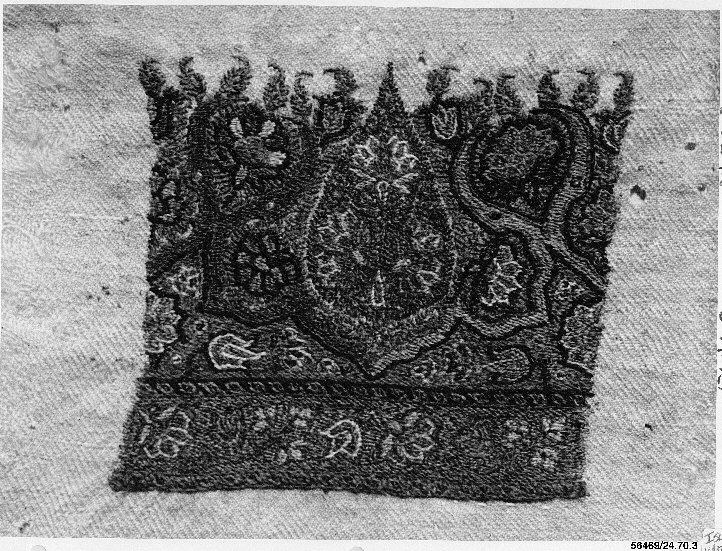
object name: shawl fragment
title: Shawl Sample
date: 1801-1833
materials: wool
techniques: embroidery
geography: india